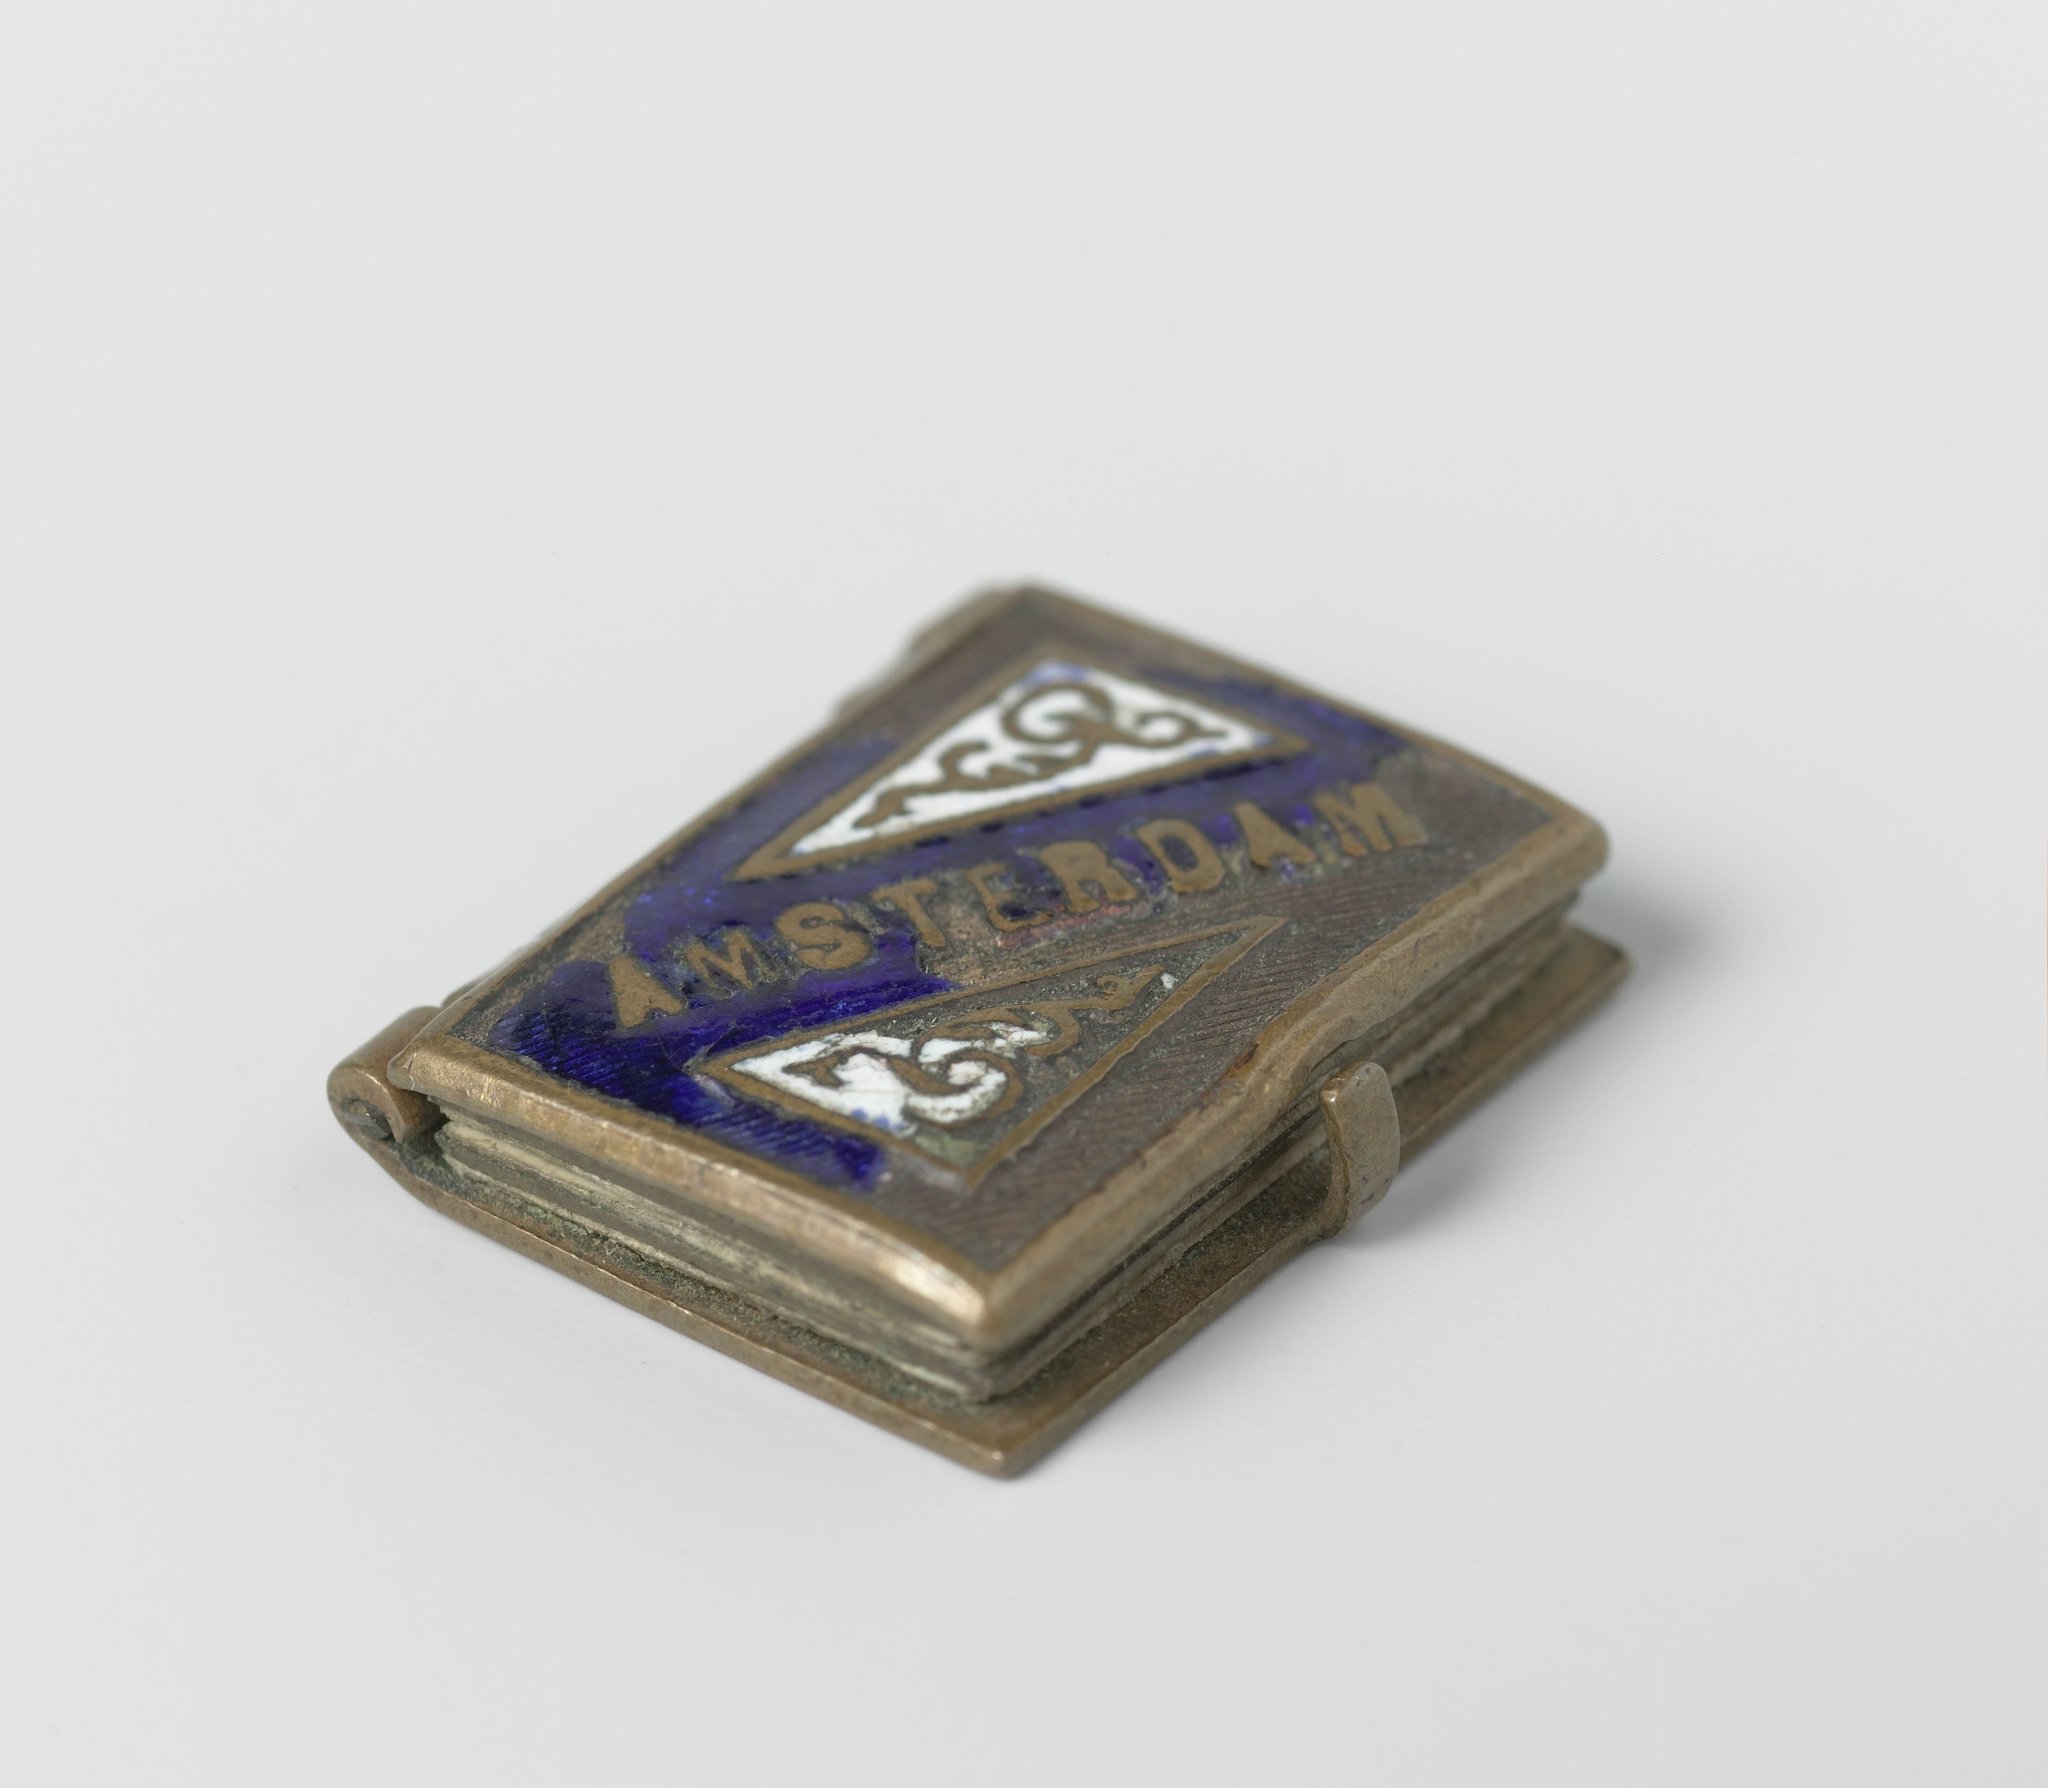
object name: pendant jewelry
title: Hanger in de vorm van een boek, met daarin 6 stadsgezichten in Amsterdam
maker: Anonymous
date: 1900-1930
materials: paper, copper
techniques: gelatin silver print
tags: city-view in general; 'veduta', amsterdam